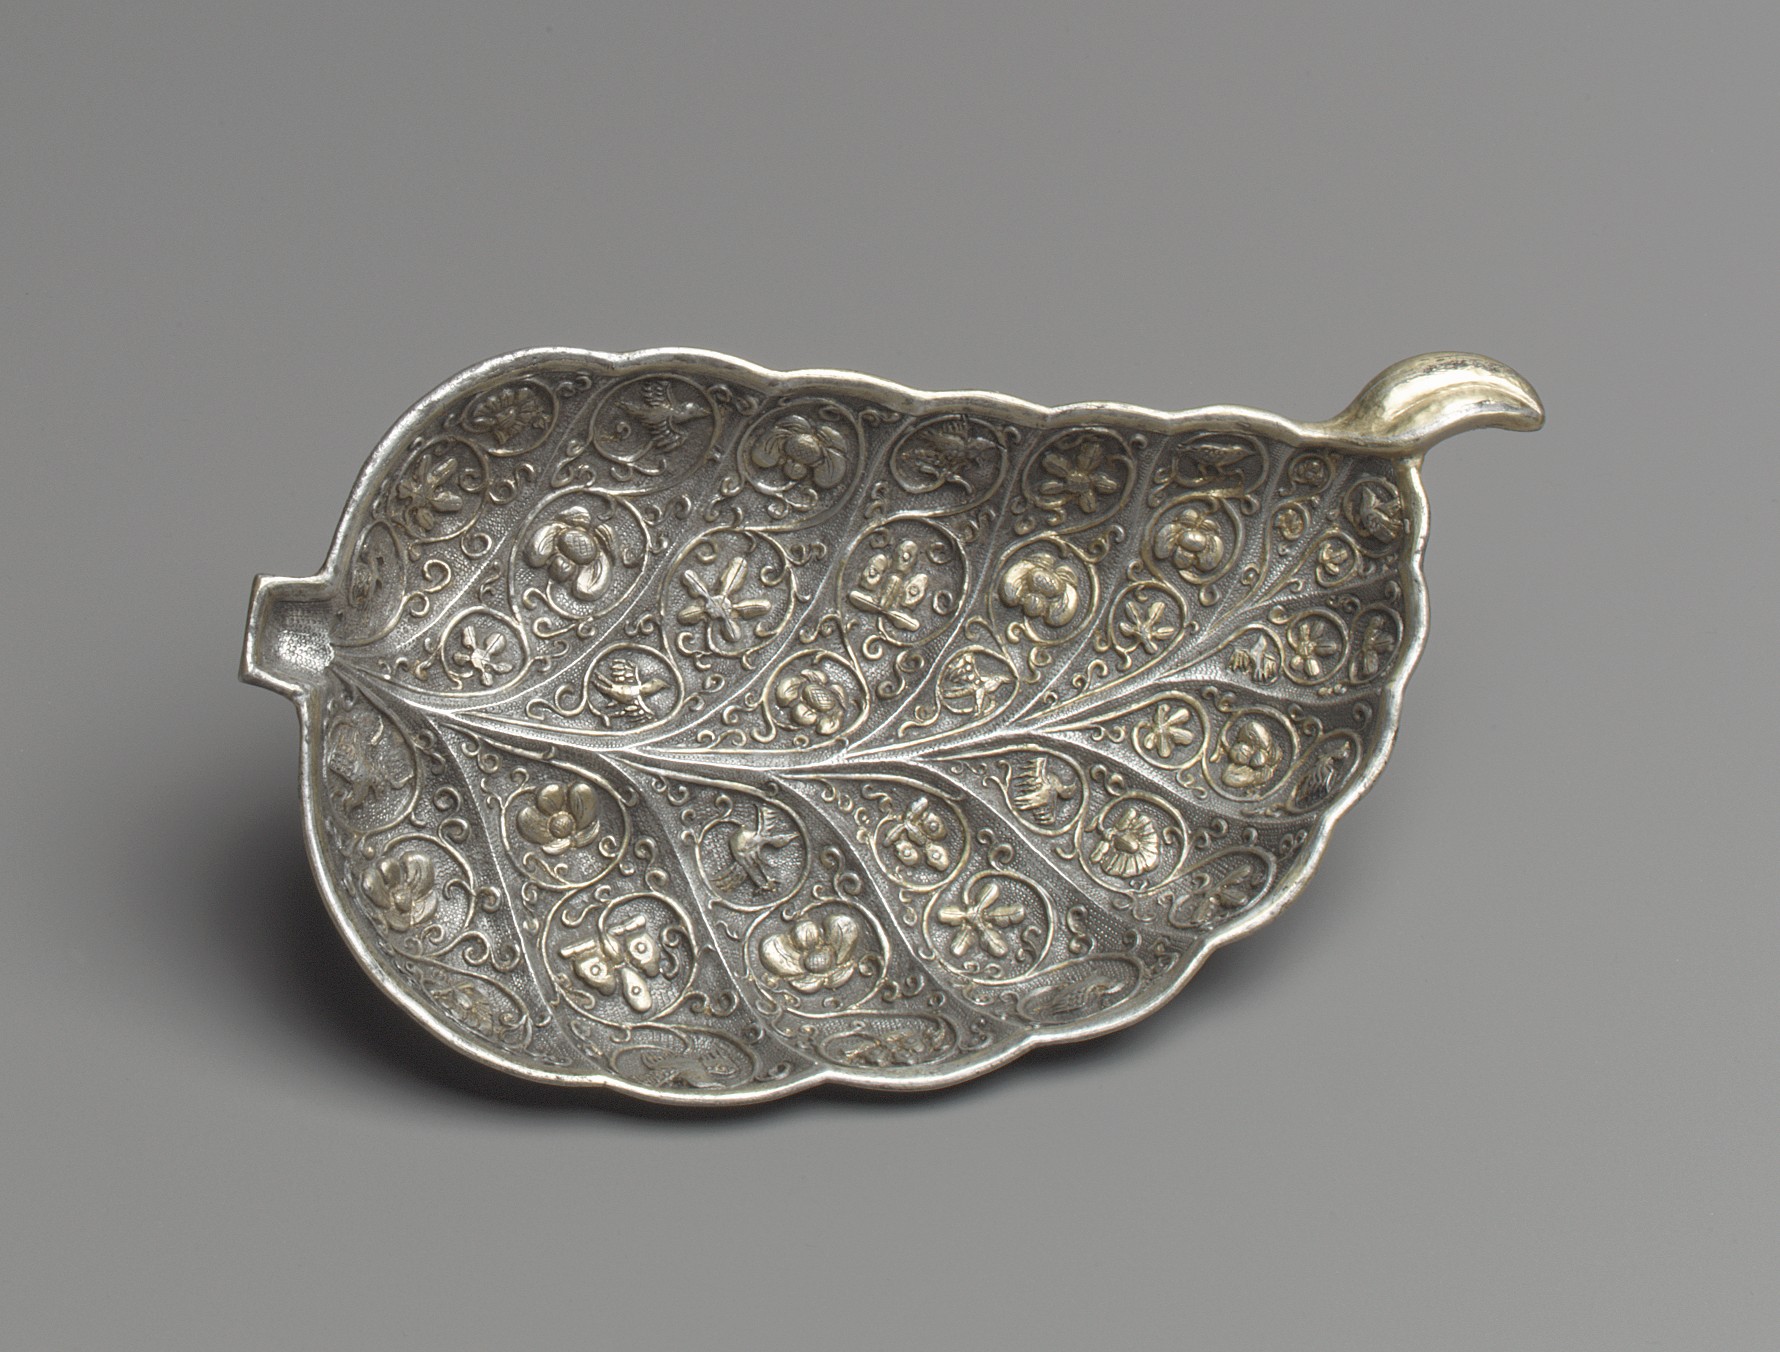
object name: dish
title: Dish in the shape of a leaf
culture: chinese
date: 667-733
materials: silver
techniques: gilding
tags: leaves